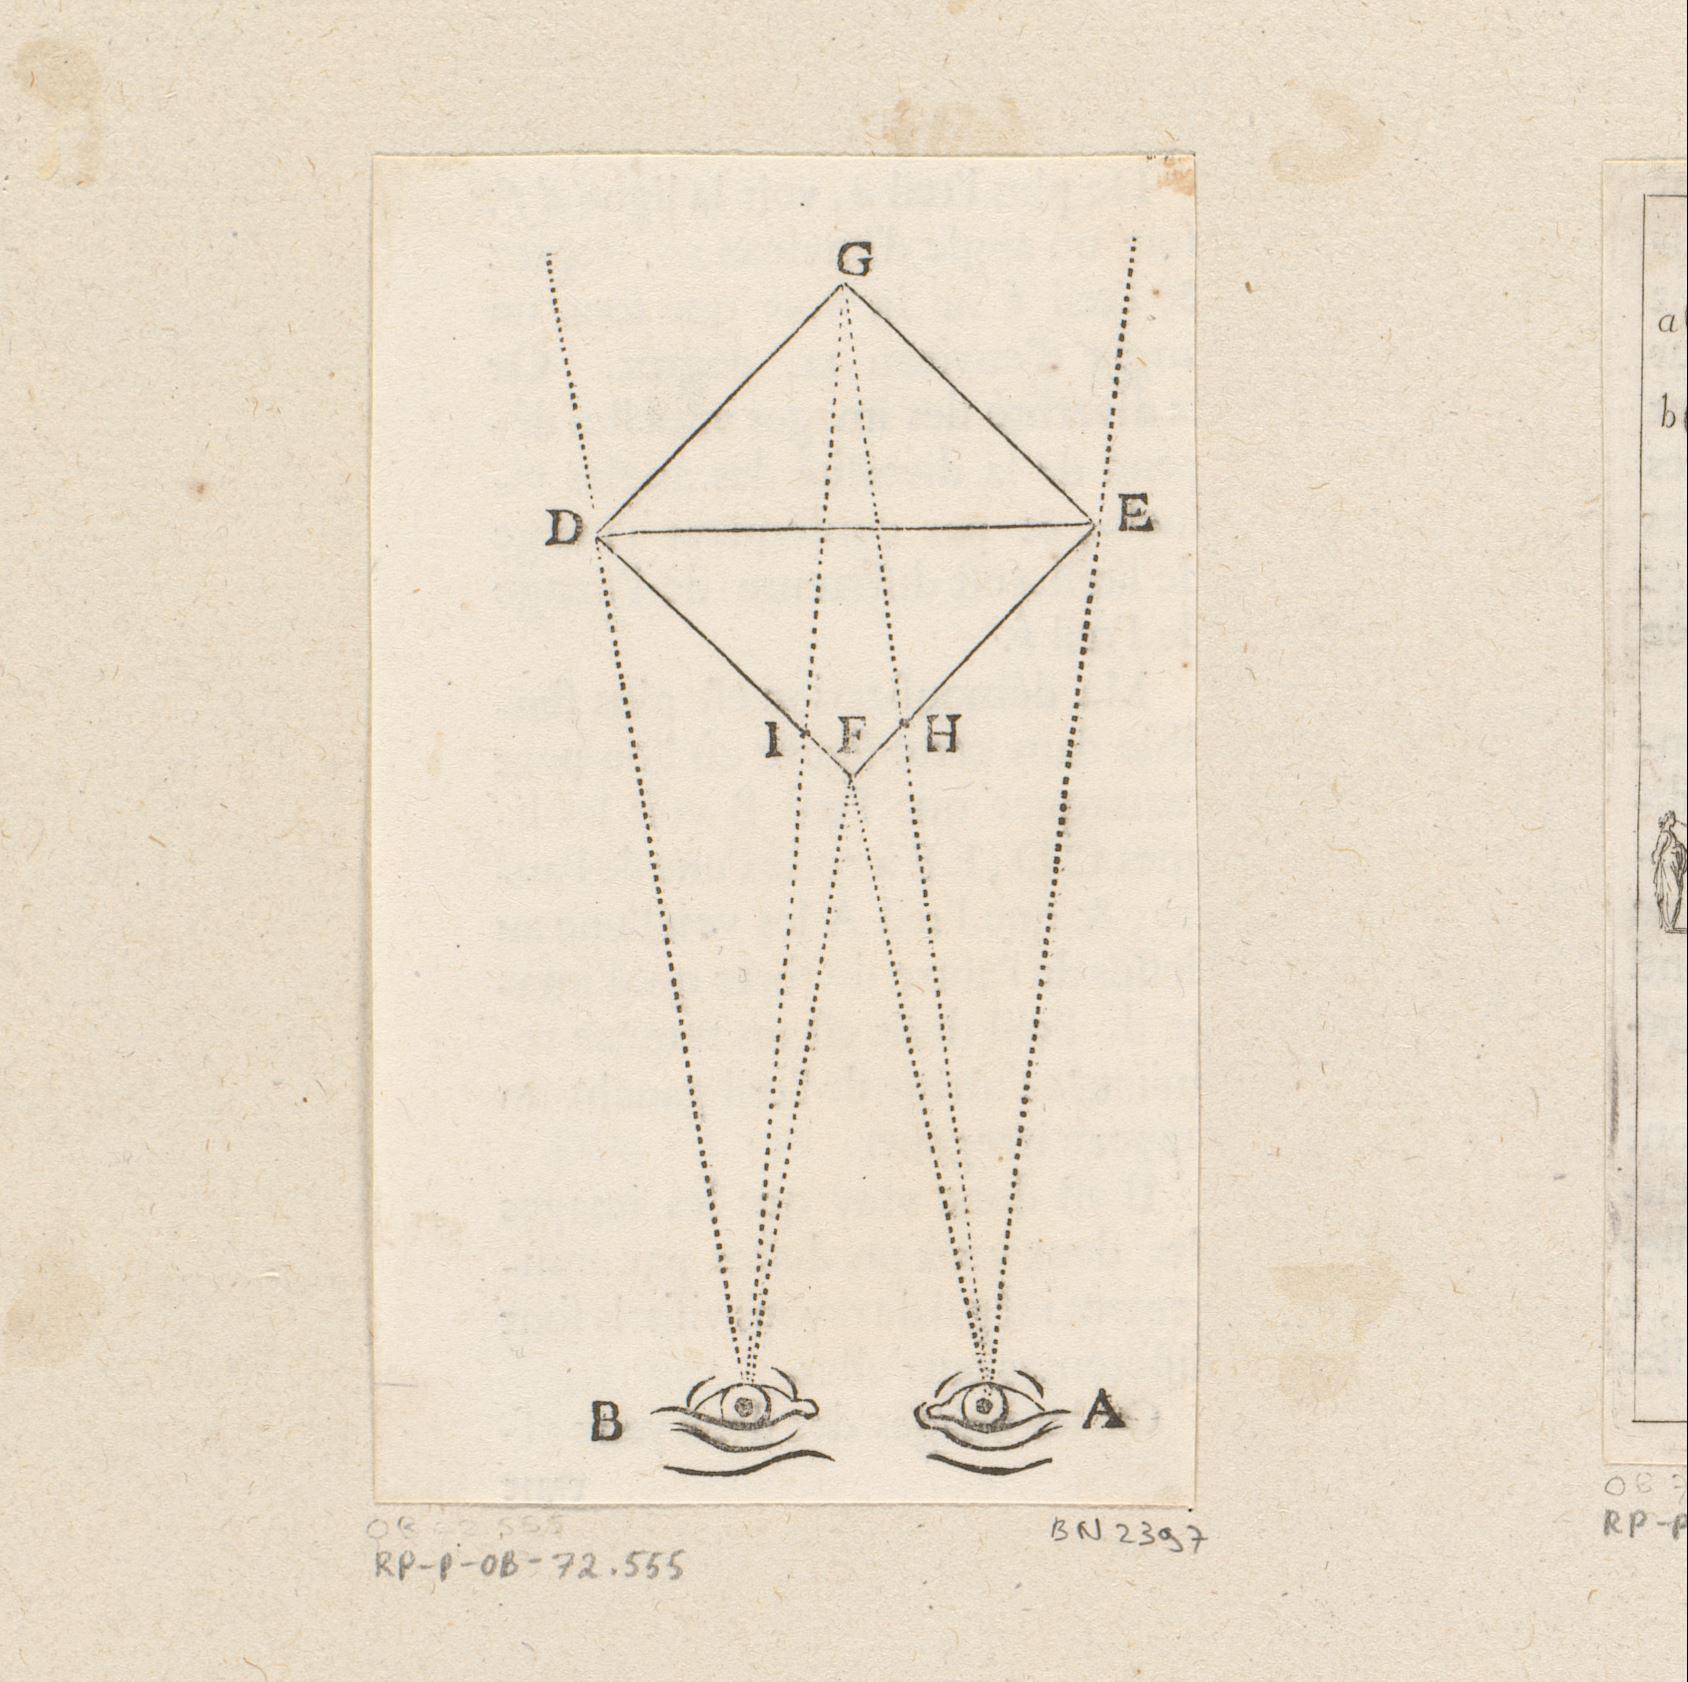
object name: book illustration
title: Twee ogen kijkend naar ruit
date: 1679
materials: paper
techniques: etching, letterpress printing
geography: france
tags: optics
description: Prent uit: Leclerc, Sébastien. Discours touchant le point de veue, dans lequel il est prouvé que les choses qu'on voit (...). Parijs: Thomas Jolly, 1679.